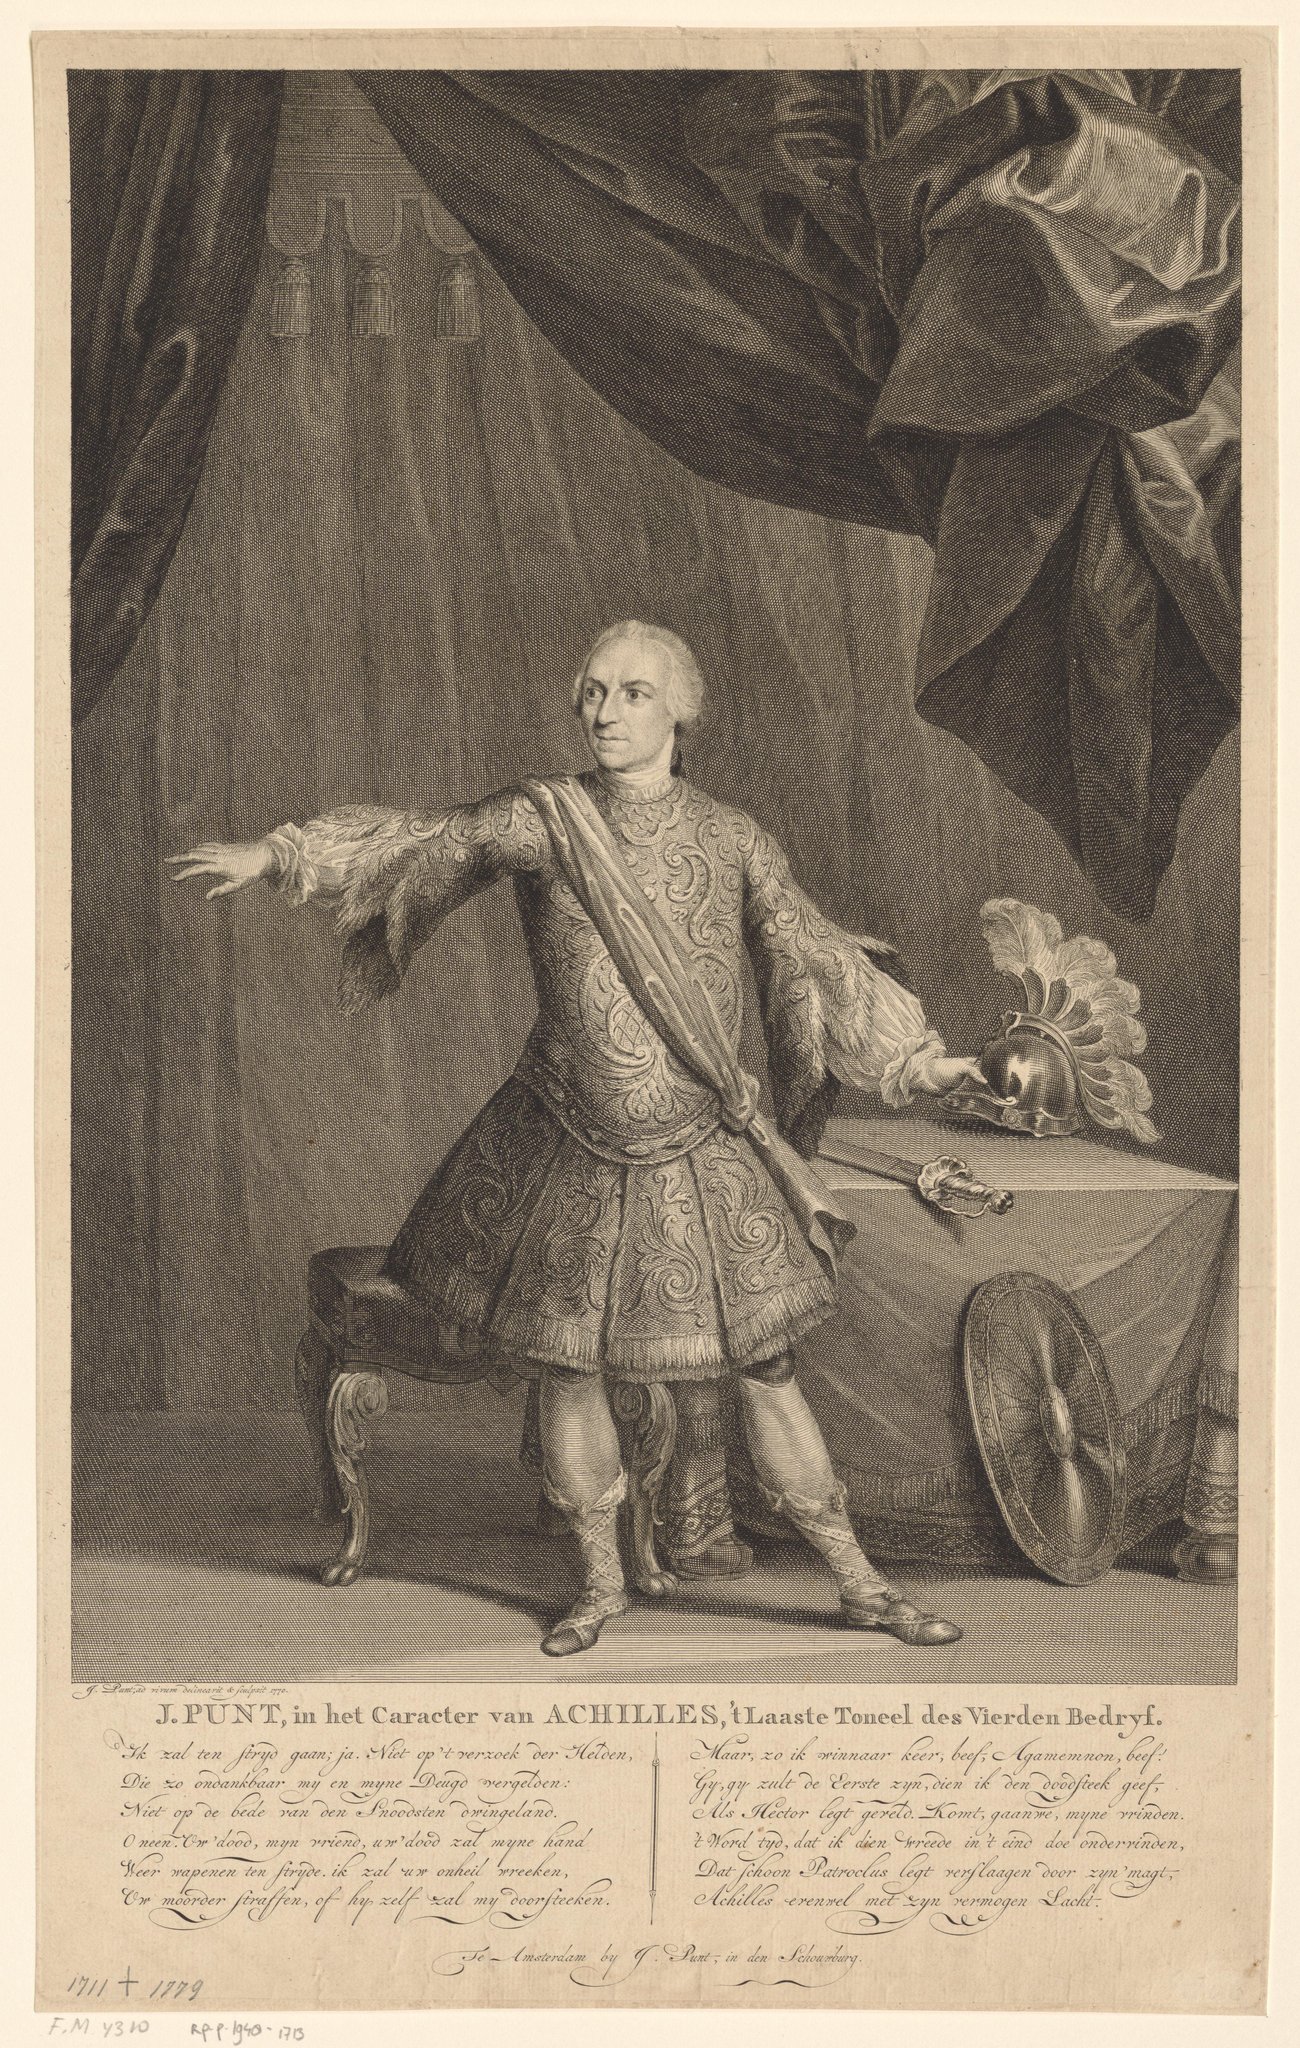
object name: print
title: J. Punt, in het Caracter van Achilles, 't Laatste Toneel des Vierden Bedryf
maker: jan punt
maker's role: draughtsman, print maker, publisher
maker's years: 1711-1779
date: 1770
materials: paper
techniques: engraving, etching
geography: amsterdam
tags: amsterdam, print maker, draughtsman, publisher, jan punt, historical persons, actor (on the stage), (story of) achilles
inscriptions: collector's mark: Lugt 2166, collector's mark: Lugt 2760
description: Jan Punt als toneelspeler op het toneel in de rol van Achilles. Hij staat bij een tafel, waar zijn schild tegenaan leunt. In de marge een twaalfregelige passage uit het toneelstuk, in twee kolommen, in het Nederlands.